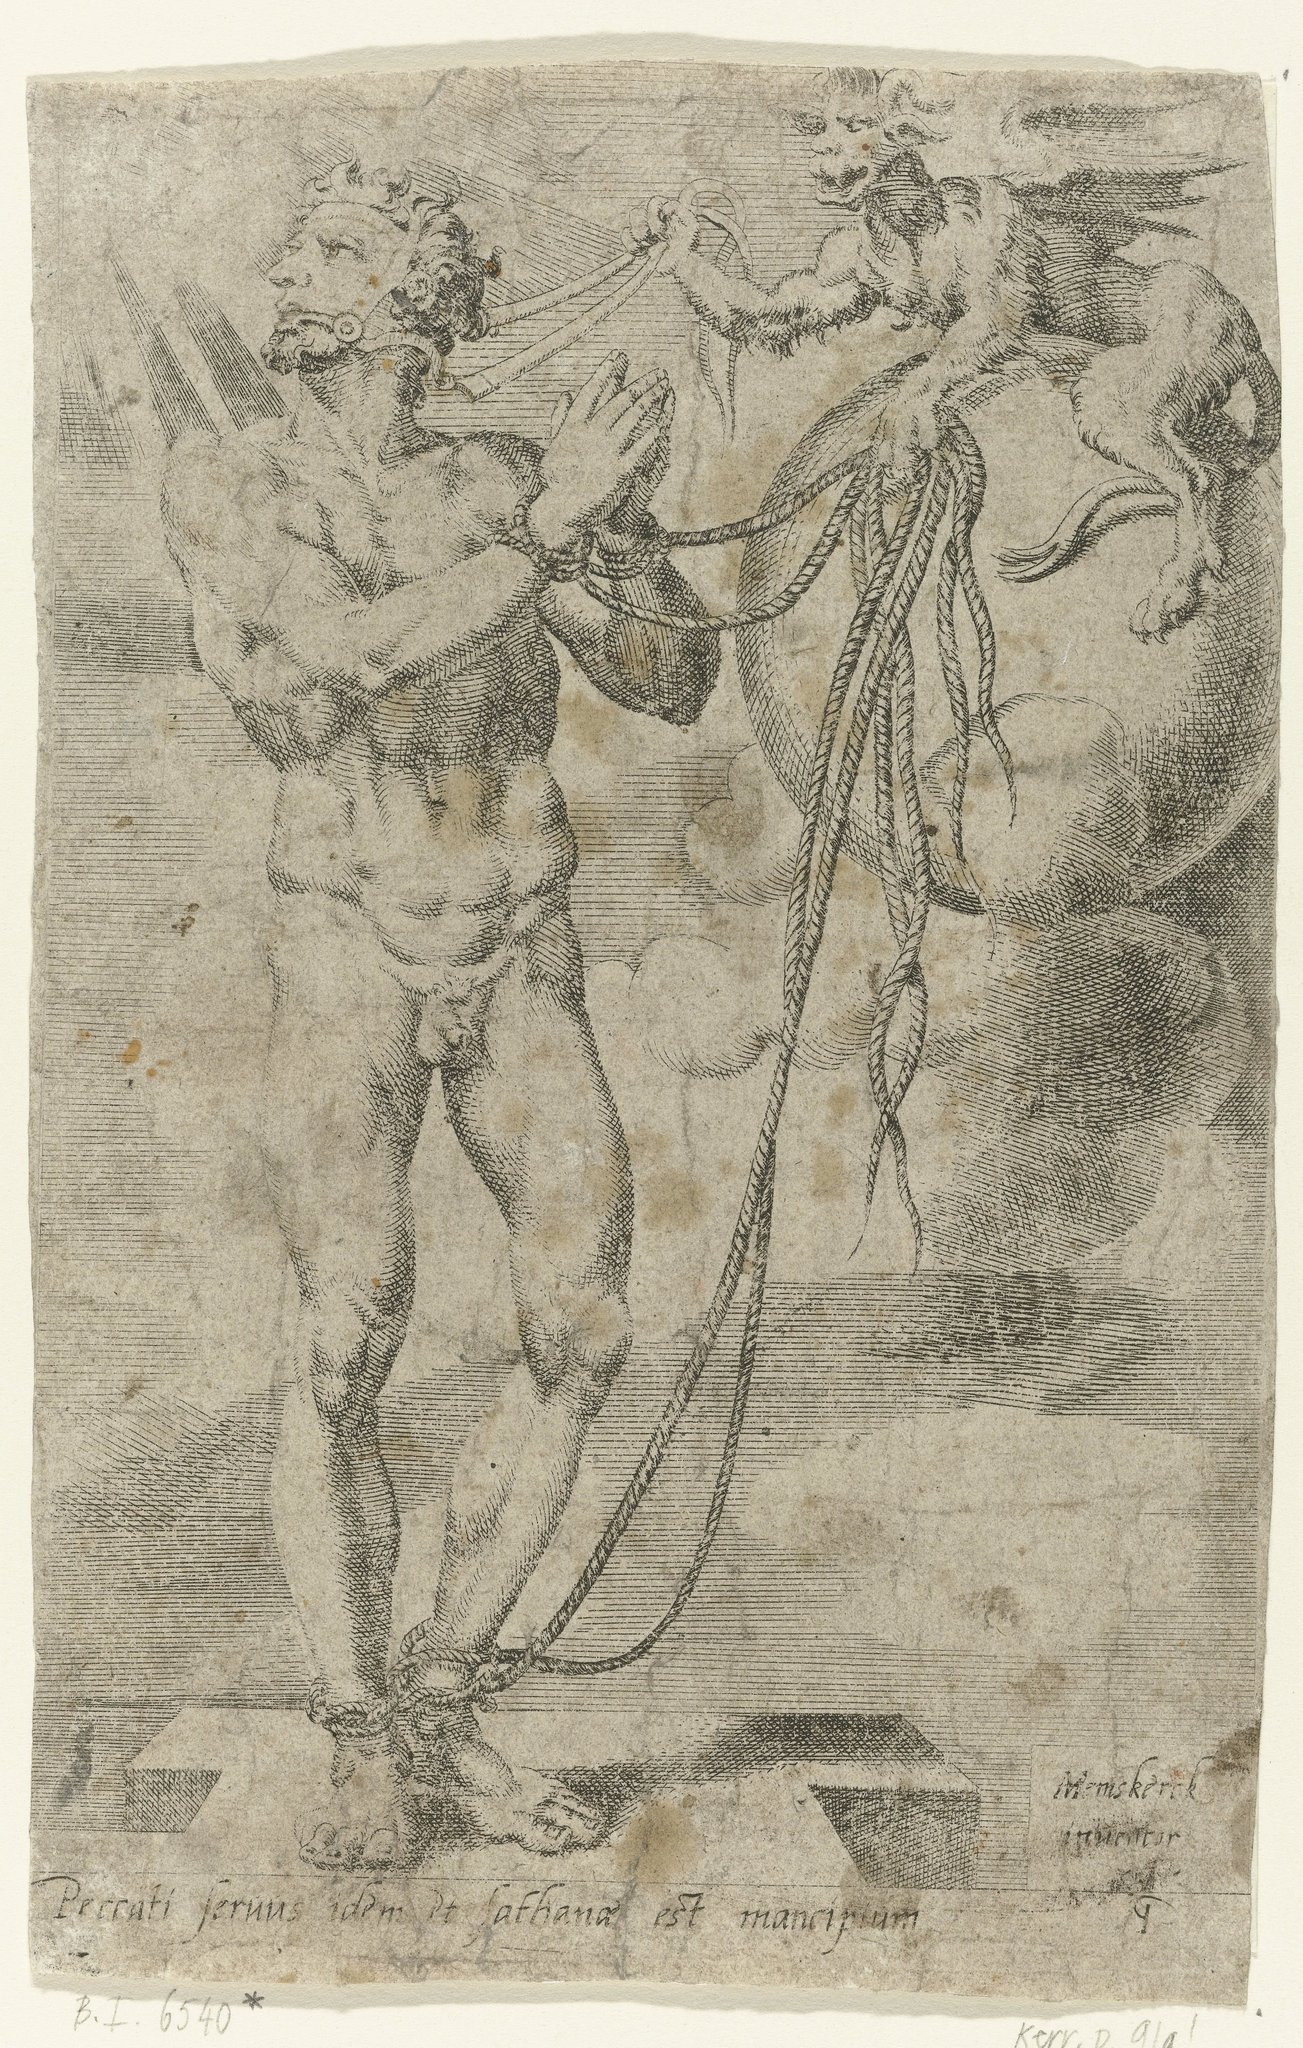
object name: print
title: Jakobs ladder of de allegorie van de weg naar eeuwige zaligheid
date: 1550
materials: paper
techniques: etching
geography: haarlem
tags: devil(s) and demons, slavery; serfs and enslaved persons, human being, man in general, eternal bliss; 'felicità eterna' (ripa) (+ symbolical representation of concept)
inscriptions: collector's mark: Lugt 2228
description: De naakte mens is met handen en voeten geketend aan een duivel die op een wereldbol ligt. De duivel heeft bovendien het hoofd van de mens beteugeld. De mens houdt zijn handen in gebed en kijkt hoopvol naar de hemelse stralen in de linkerhoek. De prent heeft een Latijns onderschrift en maakt deel uit van een veertiendelige serie met als onderwerp de manier om eeuwige zaligheid te bereiken.